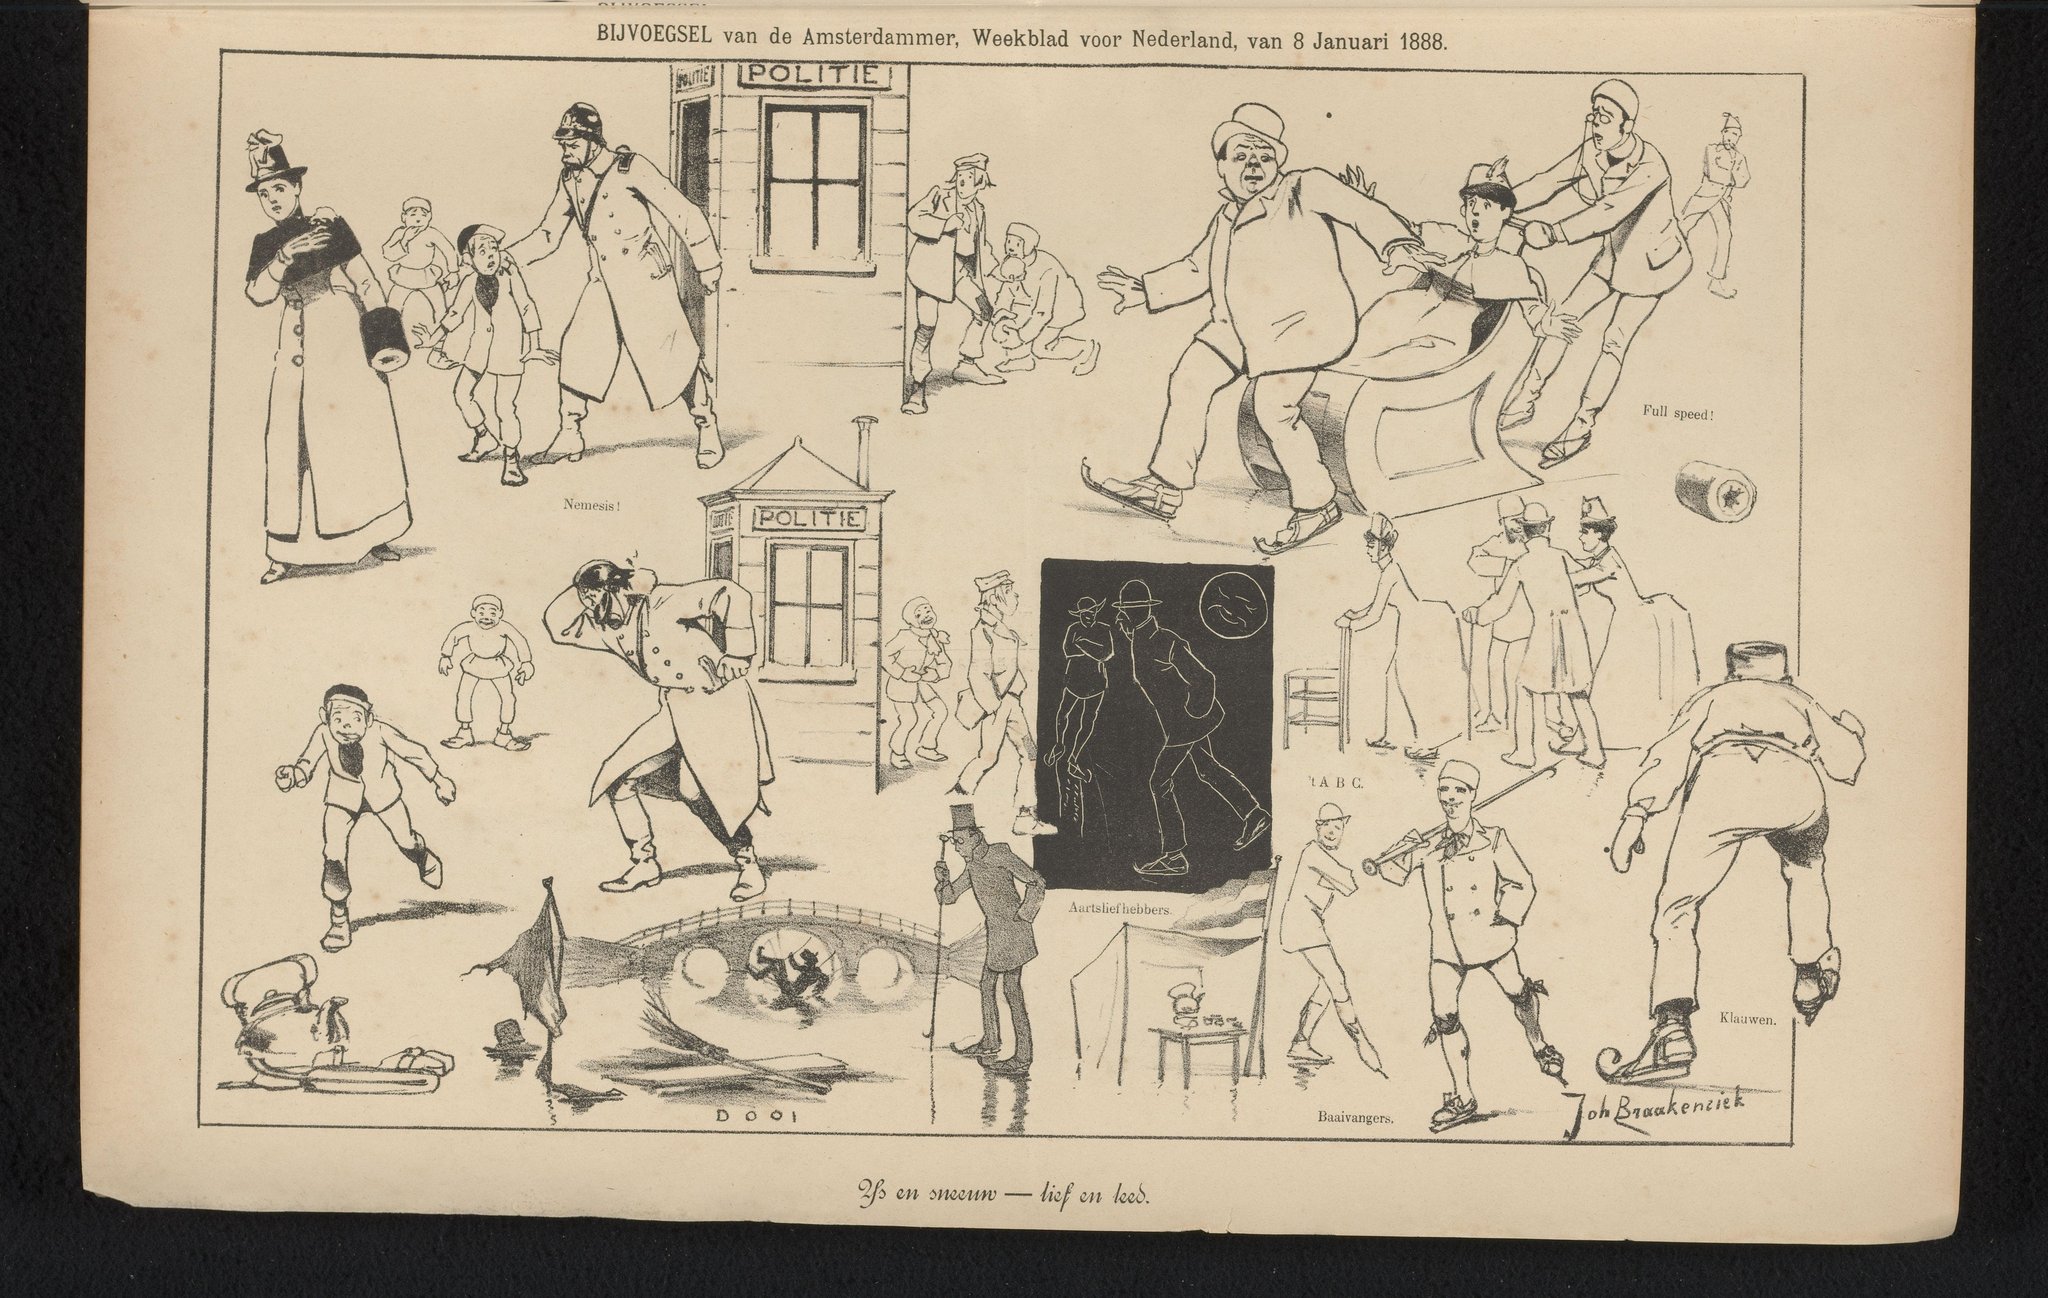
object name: cartoon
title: IJs en sneeuw - lief en leed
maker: johan braakensiek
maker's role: draughtsman, print maker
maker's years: 1858-1940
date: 1888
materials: paper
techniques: lithograph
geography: amsterdam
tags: ice ~ freezing weather, skates (winter sports), throwing snowballs, playing with snow and ice, small sleigh (winter sports)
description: Sneeuw- en ijspret in het land. Sneeuwballen gooien naar de politie, schaatsen en met de slede rijden op het ijs.